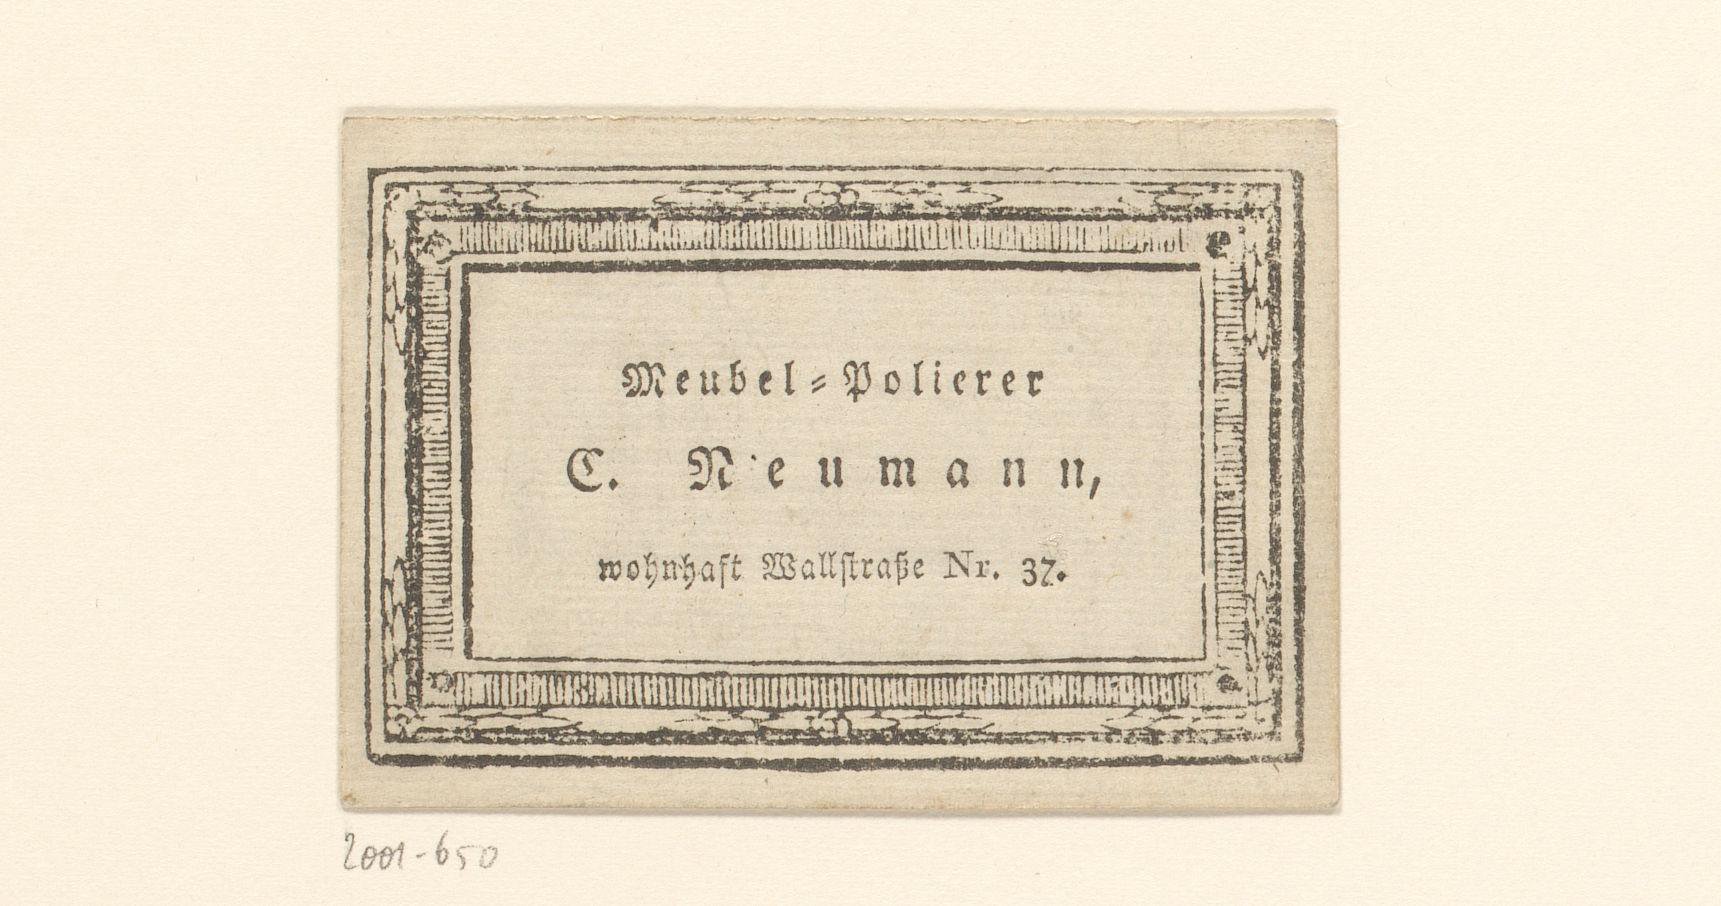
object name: print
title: Visitekaart van meubelmaker C. Neumann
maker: Anonymous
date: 1800-1899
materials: paper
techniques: letterpress printing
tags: visiting-card, calling-card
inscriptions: collector's mark: Lugt 2228, collector's mark: Lugt 2760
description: De tekst 'Meubel-Polierer C. Neumann, wohnhaft Wallstrasse Nr. 37' in een kader.